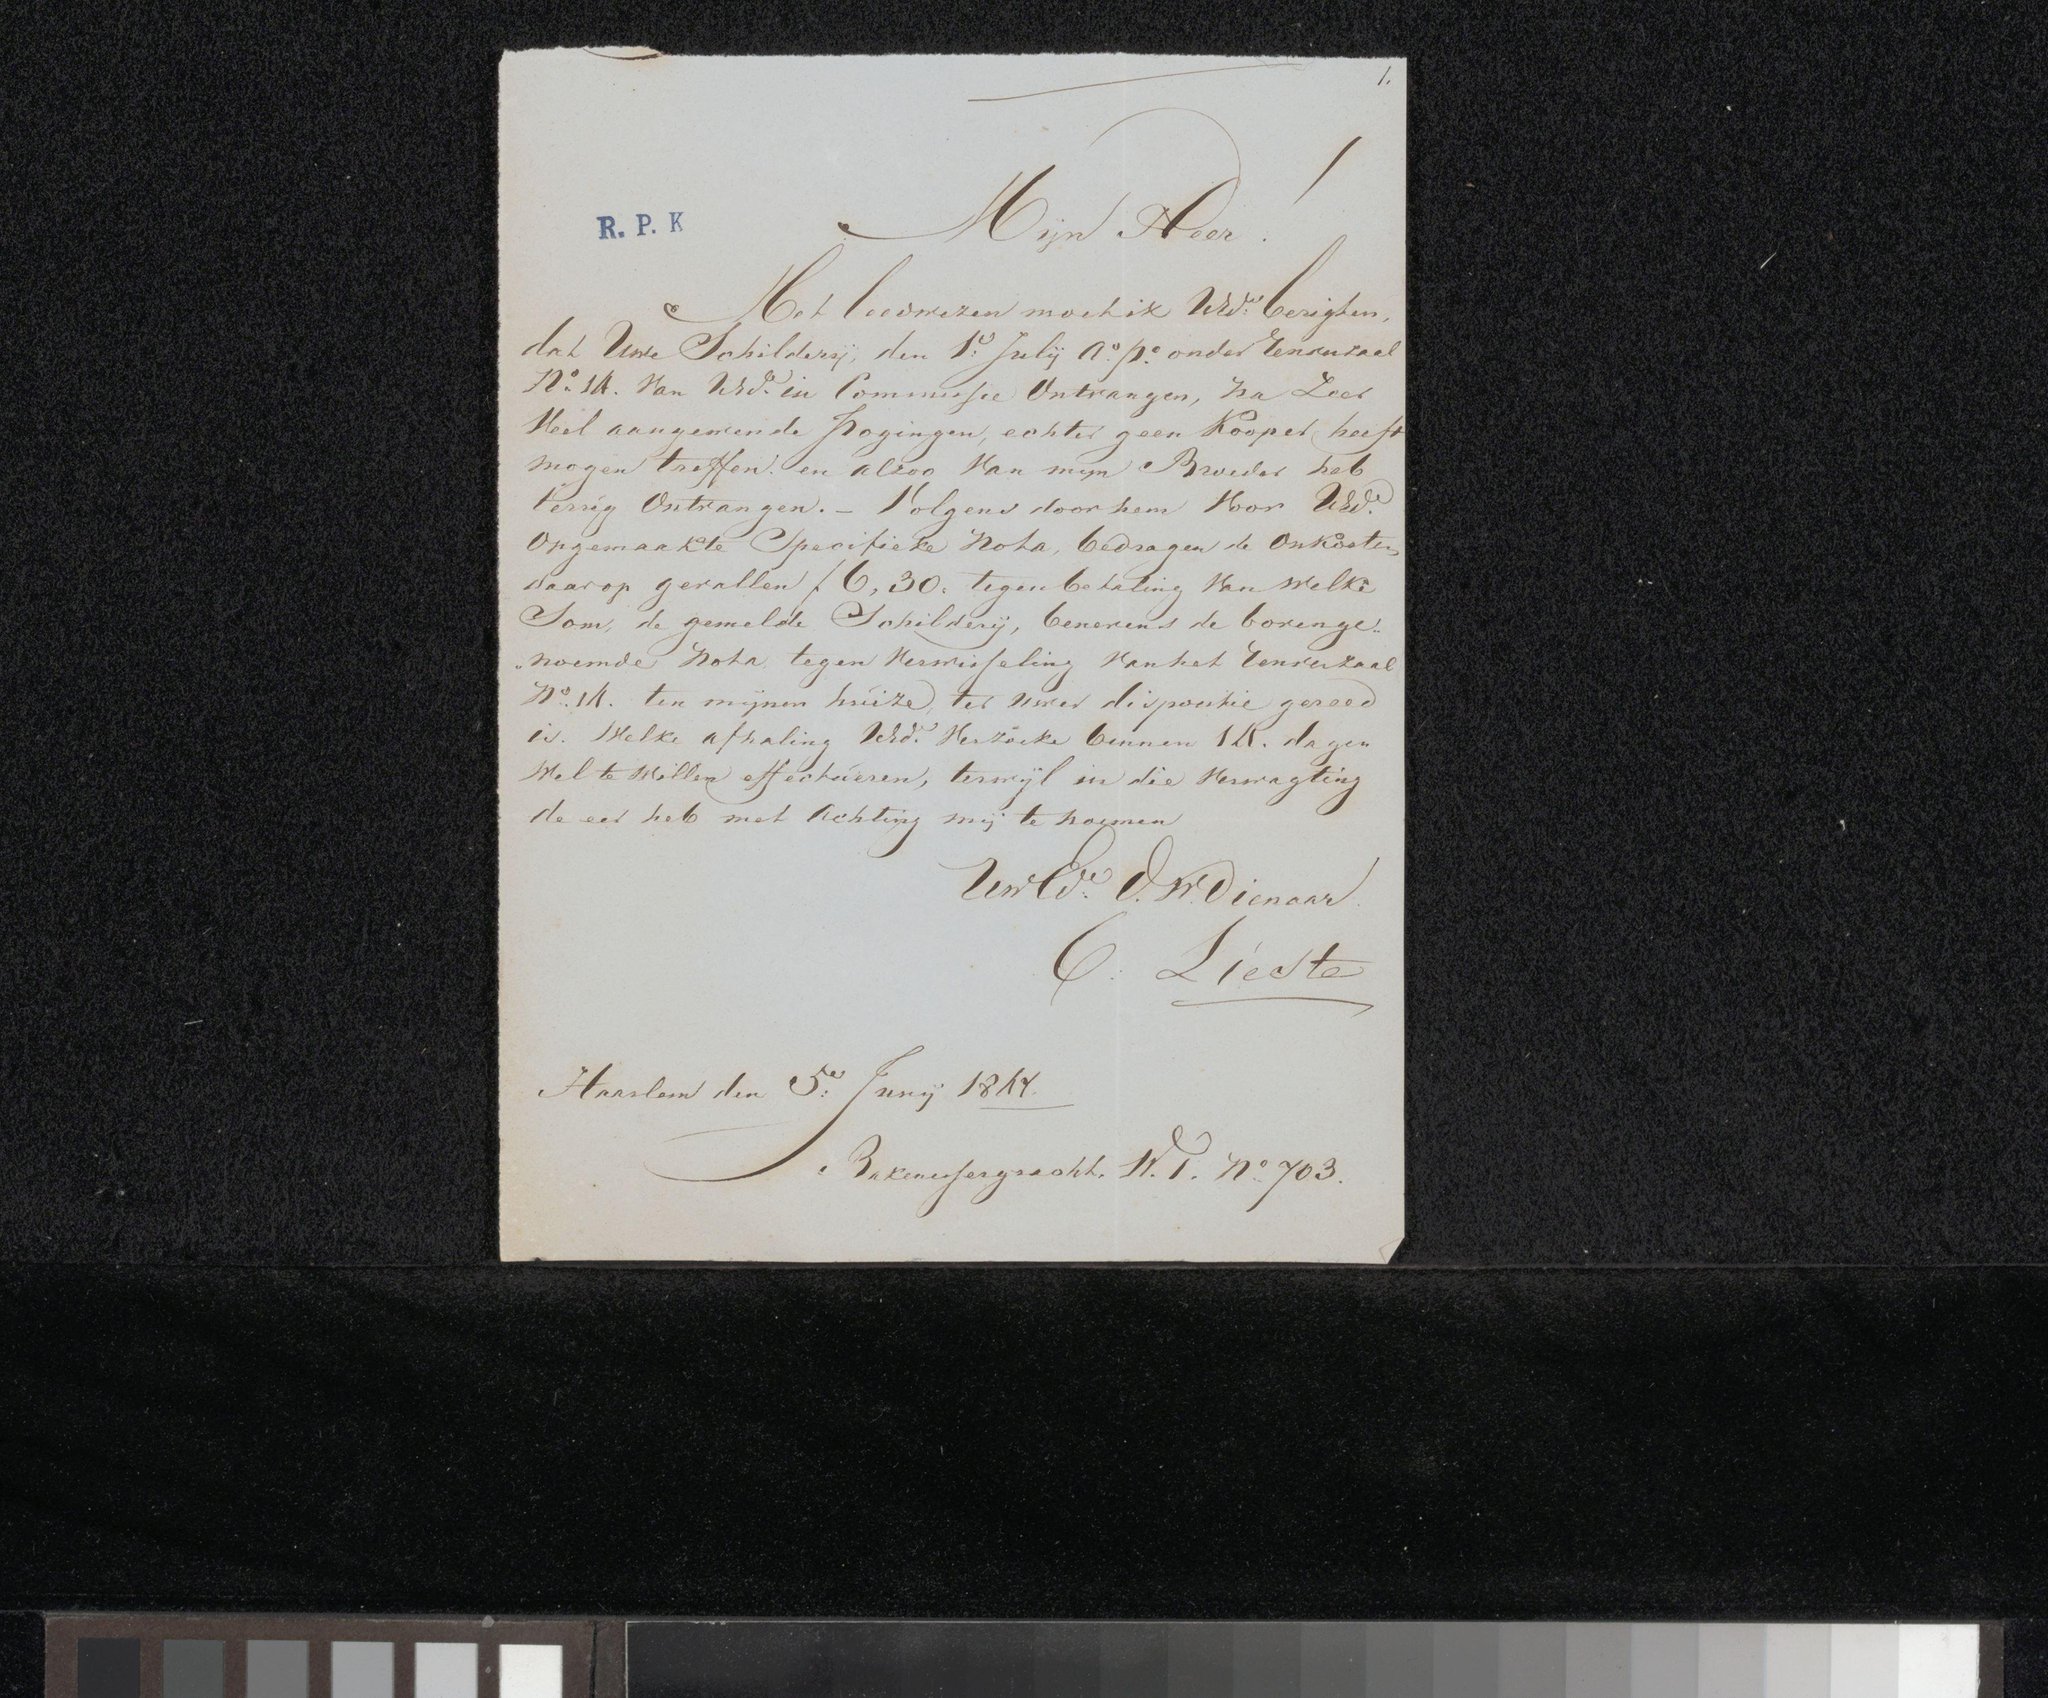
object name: letter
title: Brief aan anoniem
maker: cornelis lieste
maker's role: draughtsman, print maker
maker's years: 1817-1861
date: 1847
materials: ink, paper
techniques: pen, writing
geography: haarlem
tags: art trade, art shop, painting (including book-illumination, miniature-painting), money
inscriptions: collector's mark